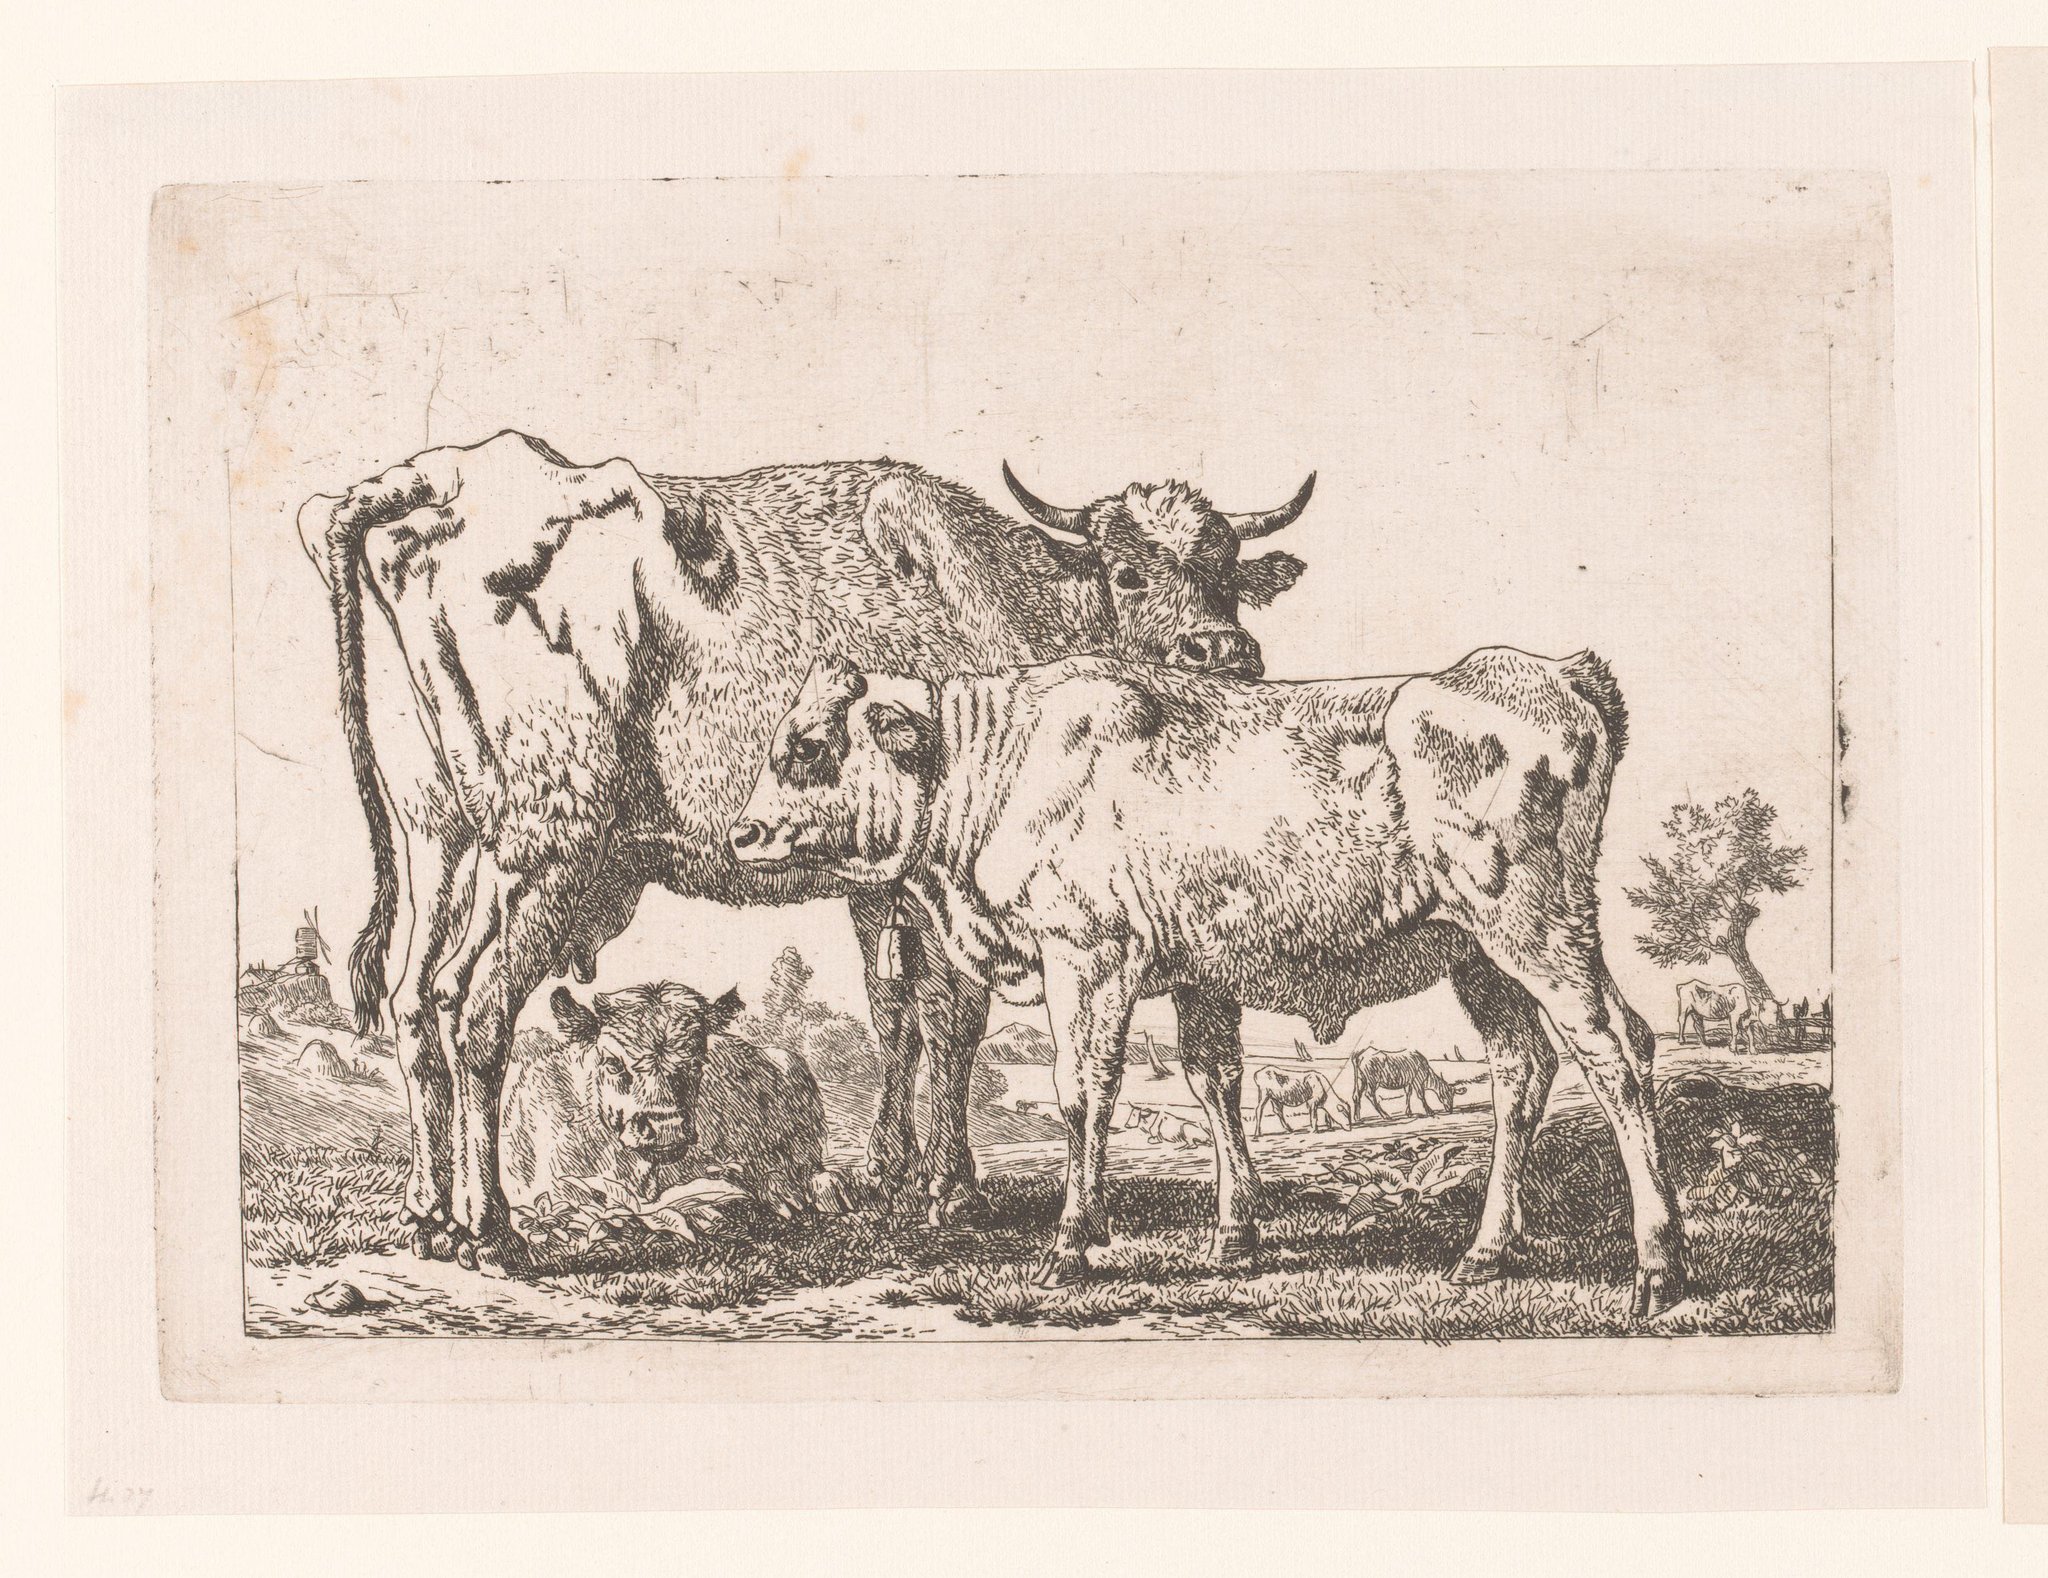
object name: print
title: Koeien en een kalf met bel om de hals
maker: jean louis demarne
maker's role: draughtsman, painter, print maker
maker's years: 1752-1829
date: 1762-1829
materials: paper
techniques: etching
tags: cow, calf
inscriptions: collector's mark: Lugt 2228